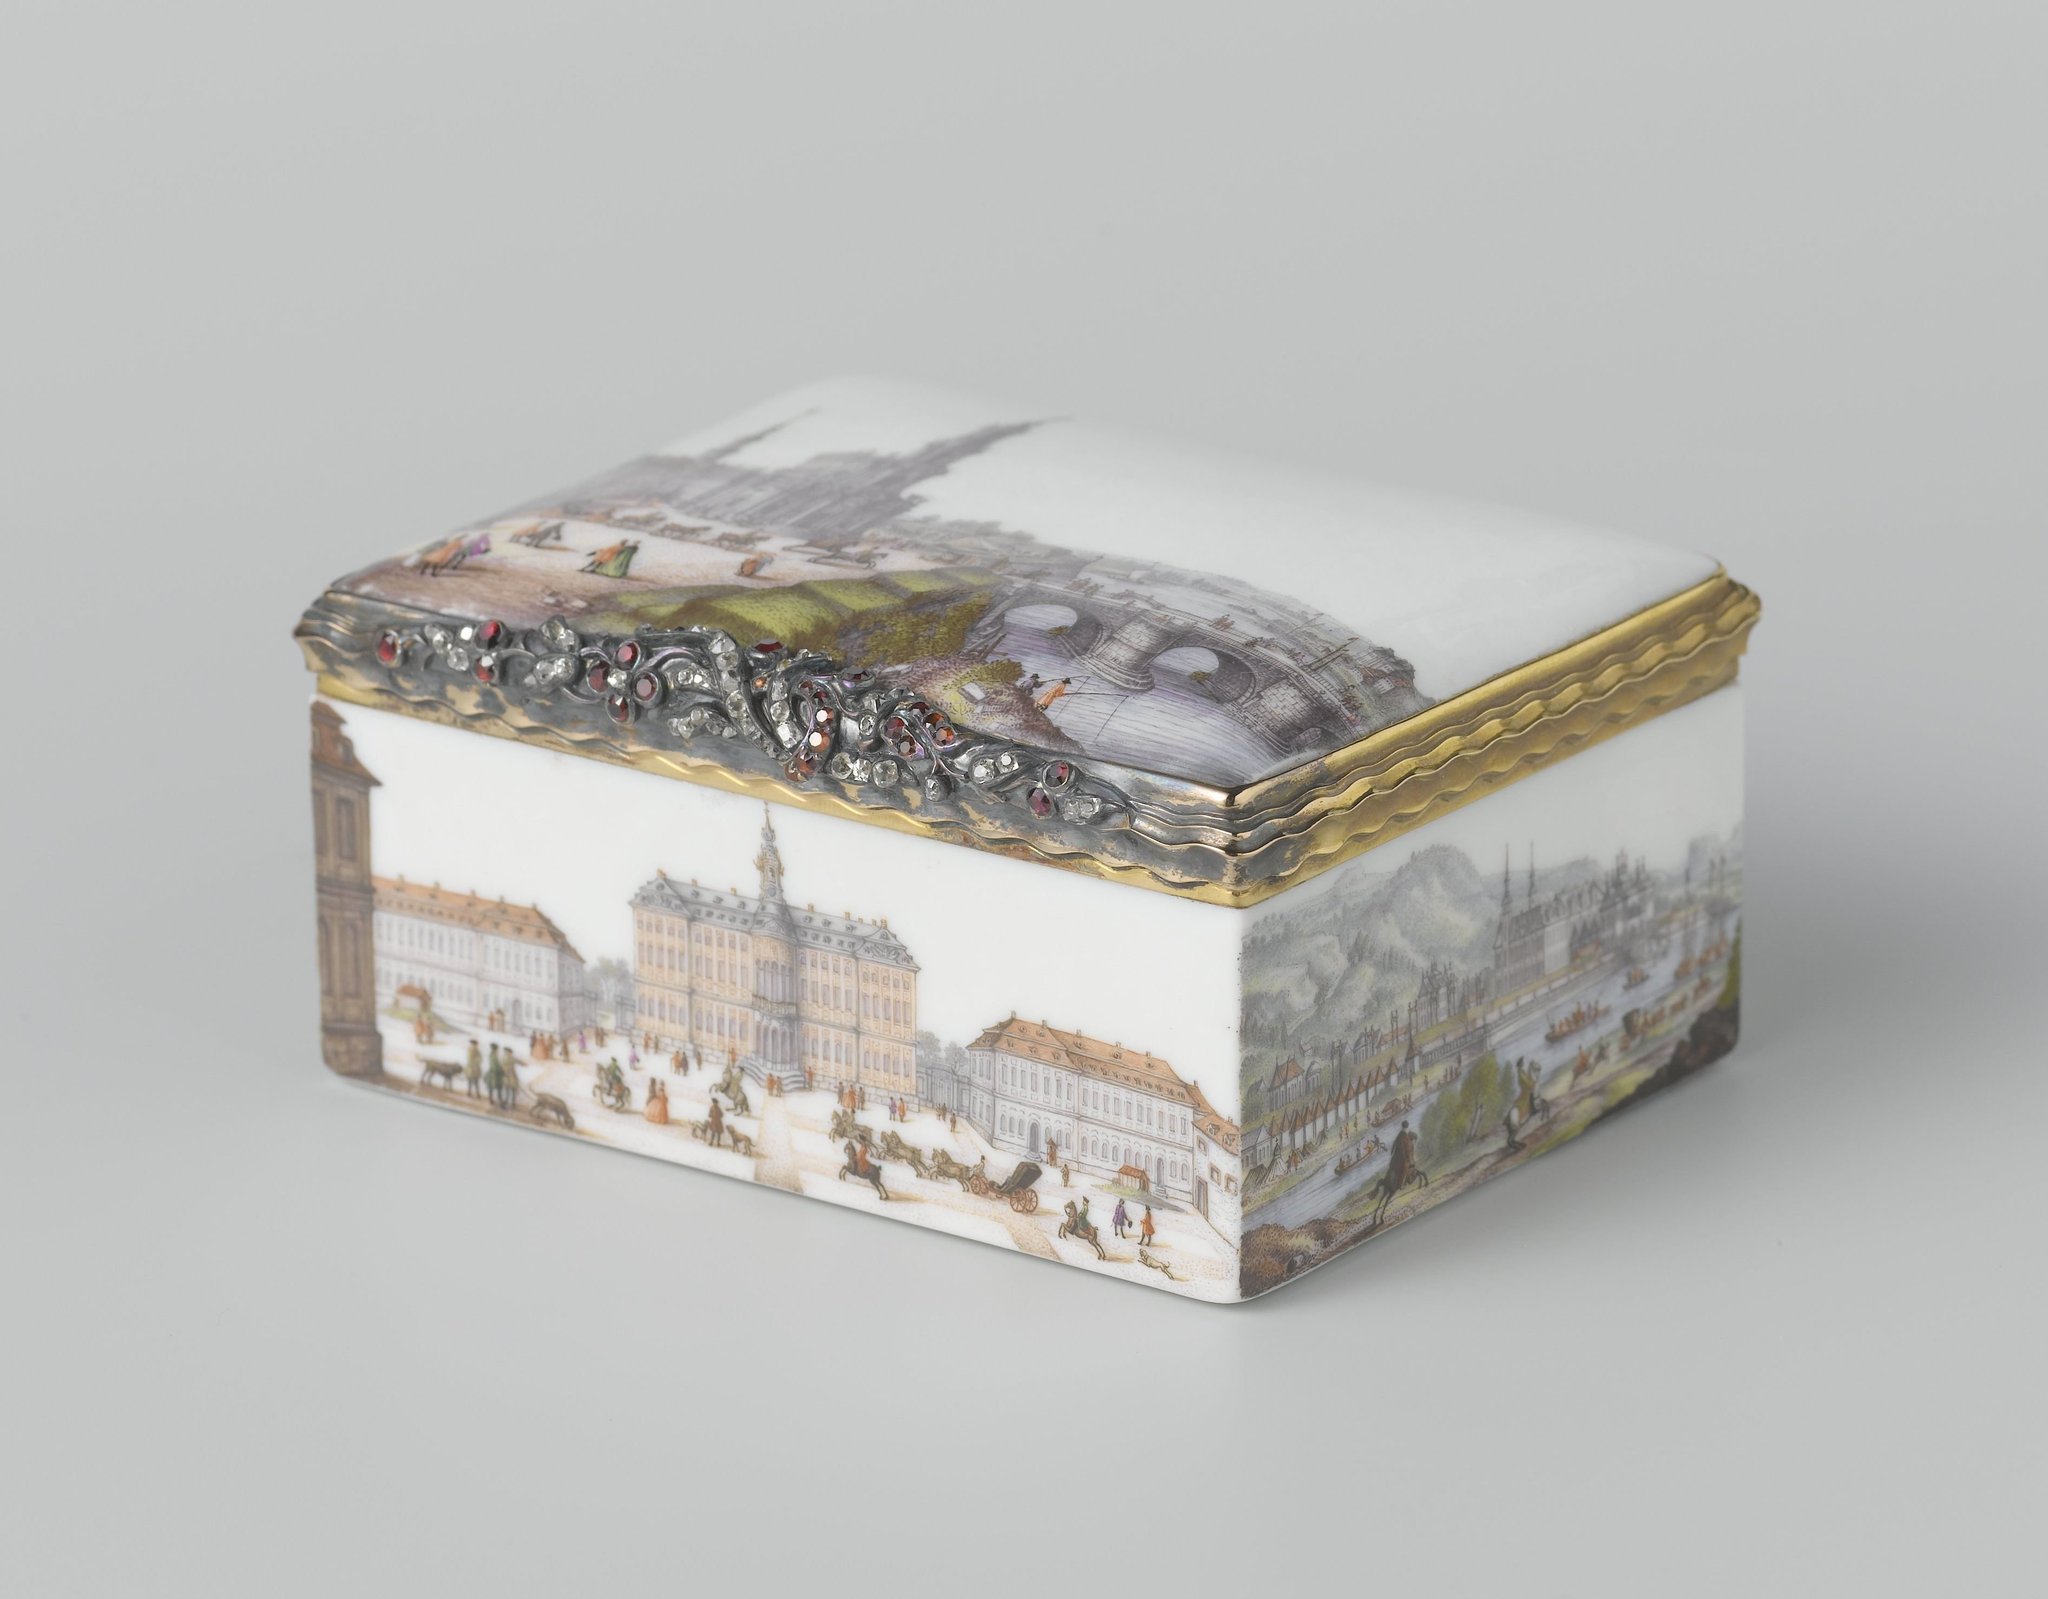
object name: snuffbox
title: Snuffbox with scenes of Saxon castles and a view of Dresden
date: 1750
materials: diamond, gemstone, gold, porcelain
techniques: painted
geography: meissen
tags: palace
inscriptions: factory mark: ‘AR’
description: Meissener Porzellan Manufaktur Meissen, c. 1750 hard-paste porcelain, gold, diamonds, garnets